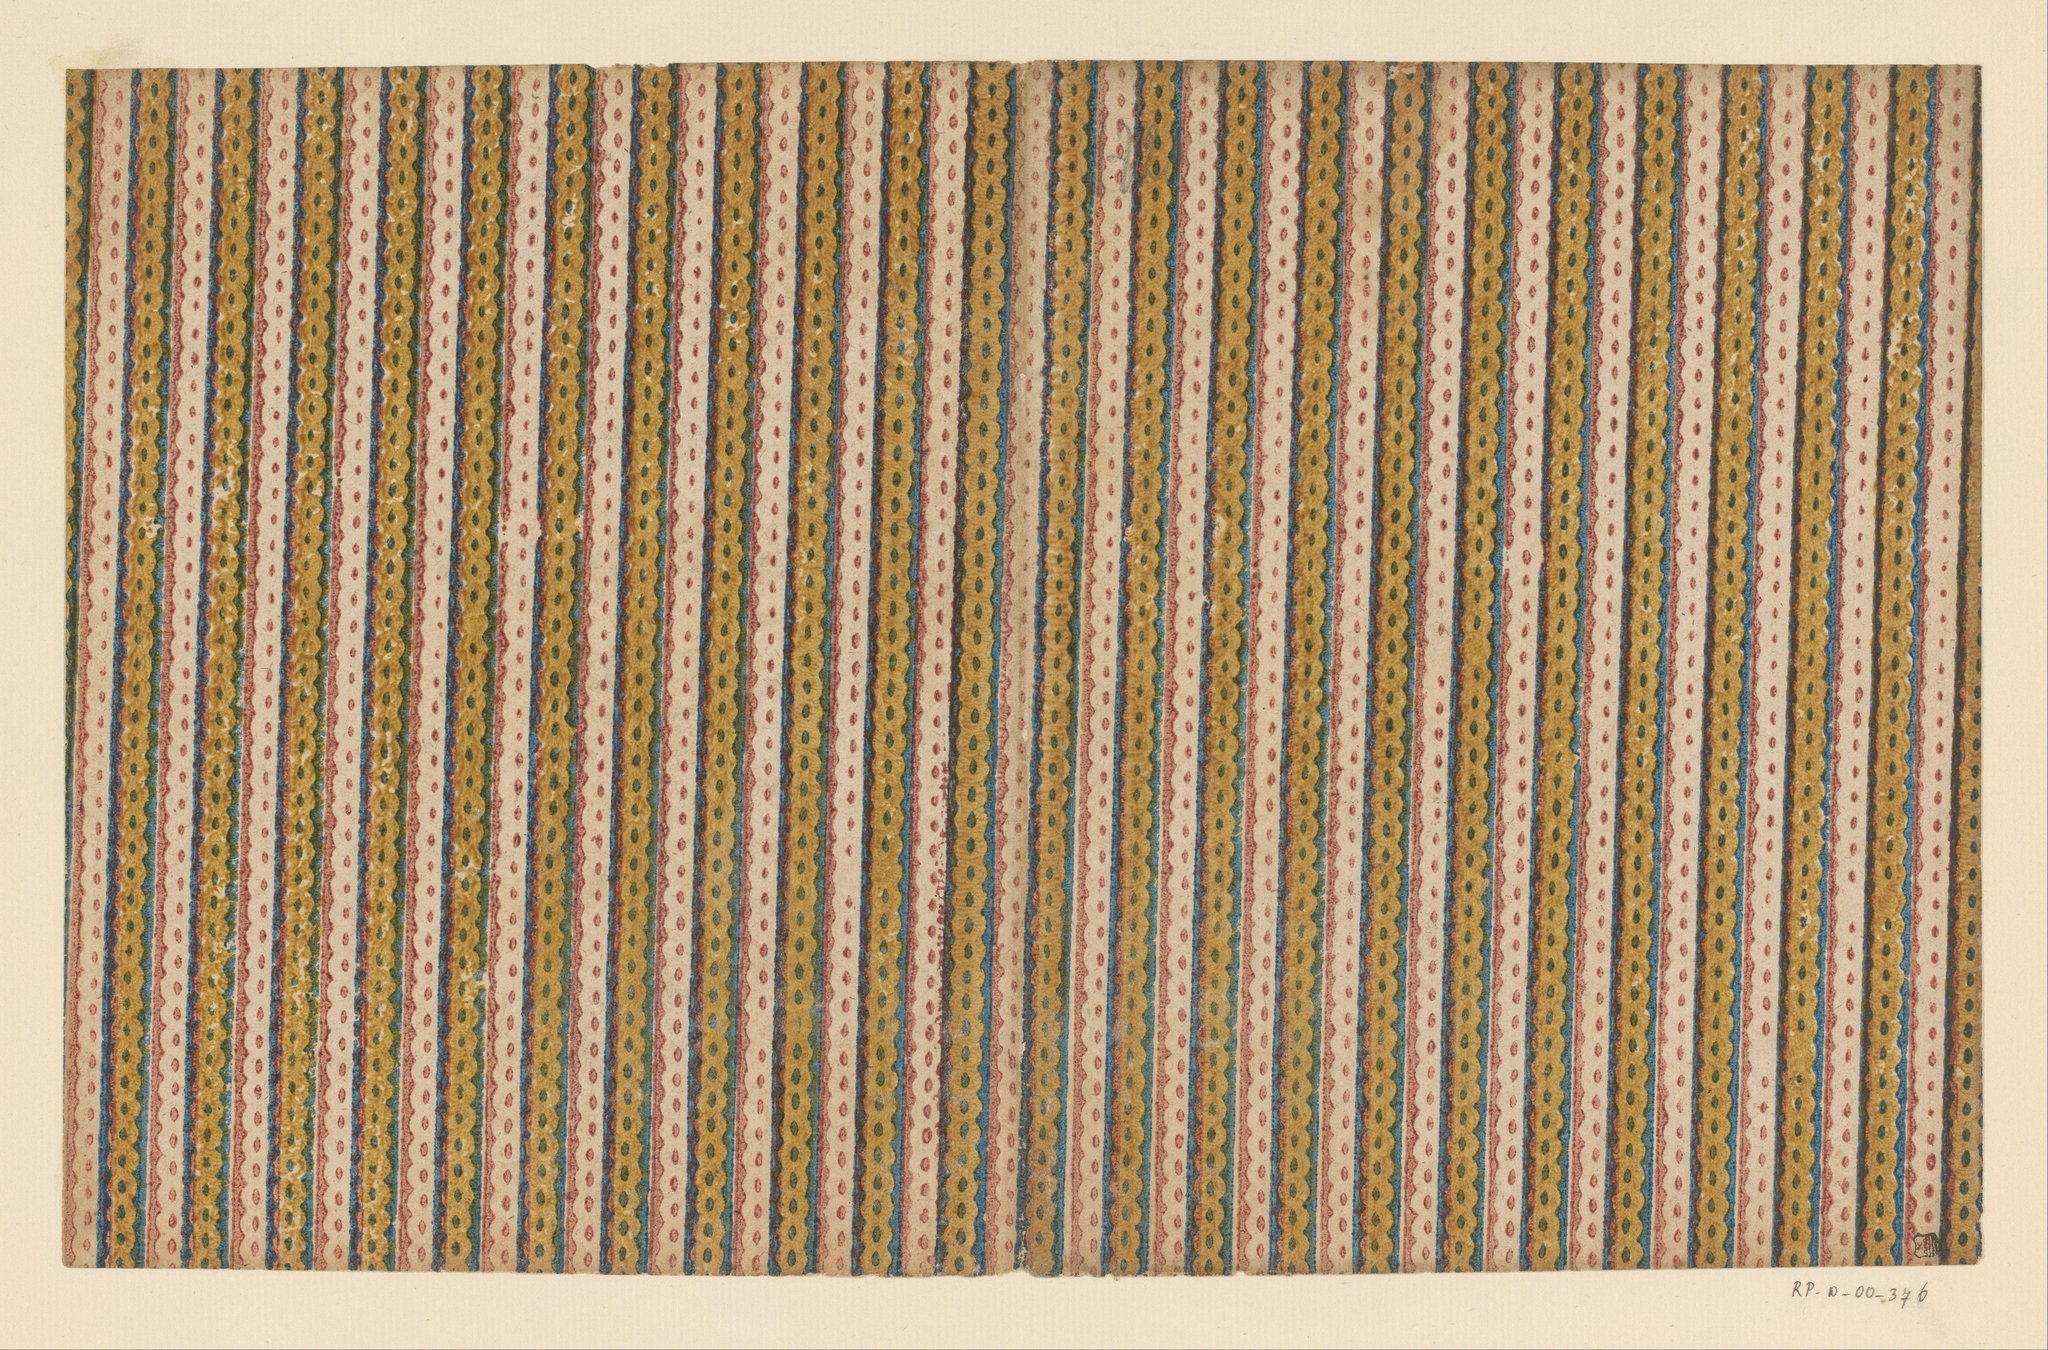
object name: printed paper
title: Blad met banenpatroon van alternerend gekleurde sierlijsten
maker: Anonymous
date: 1700-1850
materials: paper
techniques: printing block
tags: ornament ~ geometric motifs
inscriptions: collector's mark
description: Blad met banenpatroon van alternerend gekleurde sierlijsten.